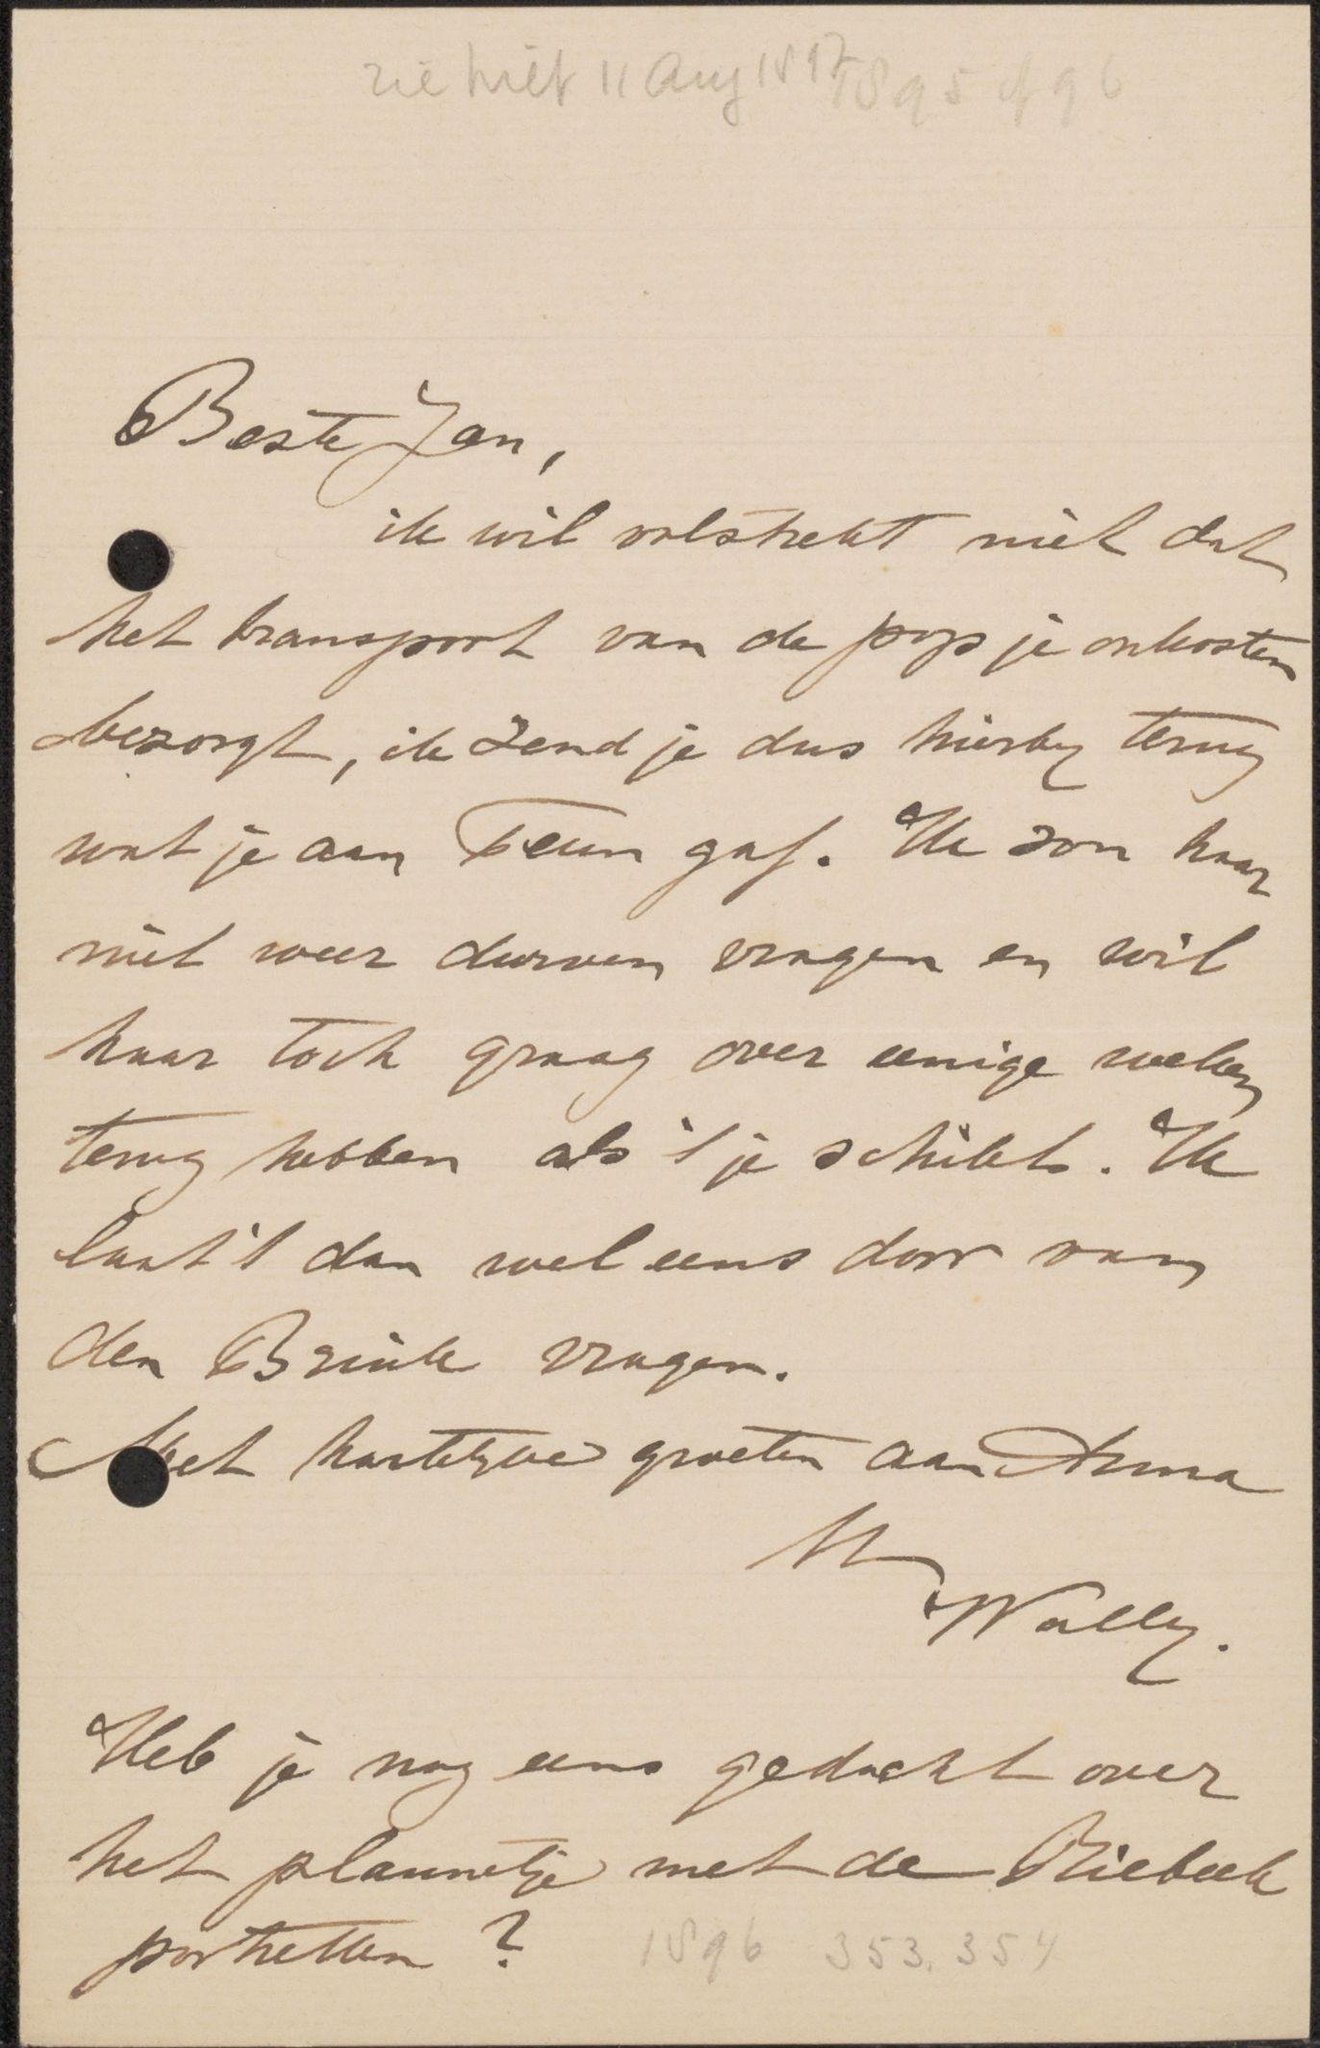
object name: letter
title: Brief aan Jan Veth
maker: wally moes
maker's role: draughtsman, print maker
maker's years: 1856-1918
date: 1874-1918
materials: ink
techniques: pen, writing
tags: dordrecht, painter, designer, jan veth, historical persons (portraits and scenes from the life)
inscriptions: watermark, collector's mark: ‘RPK’